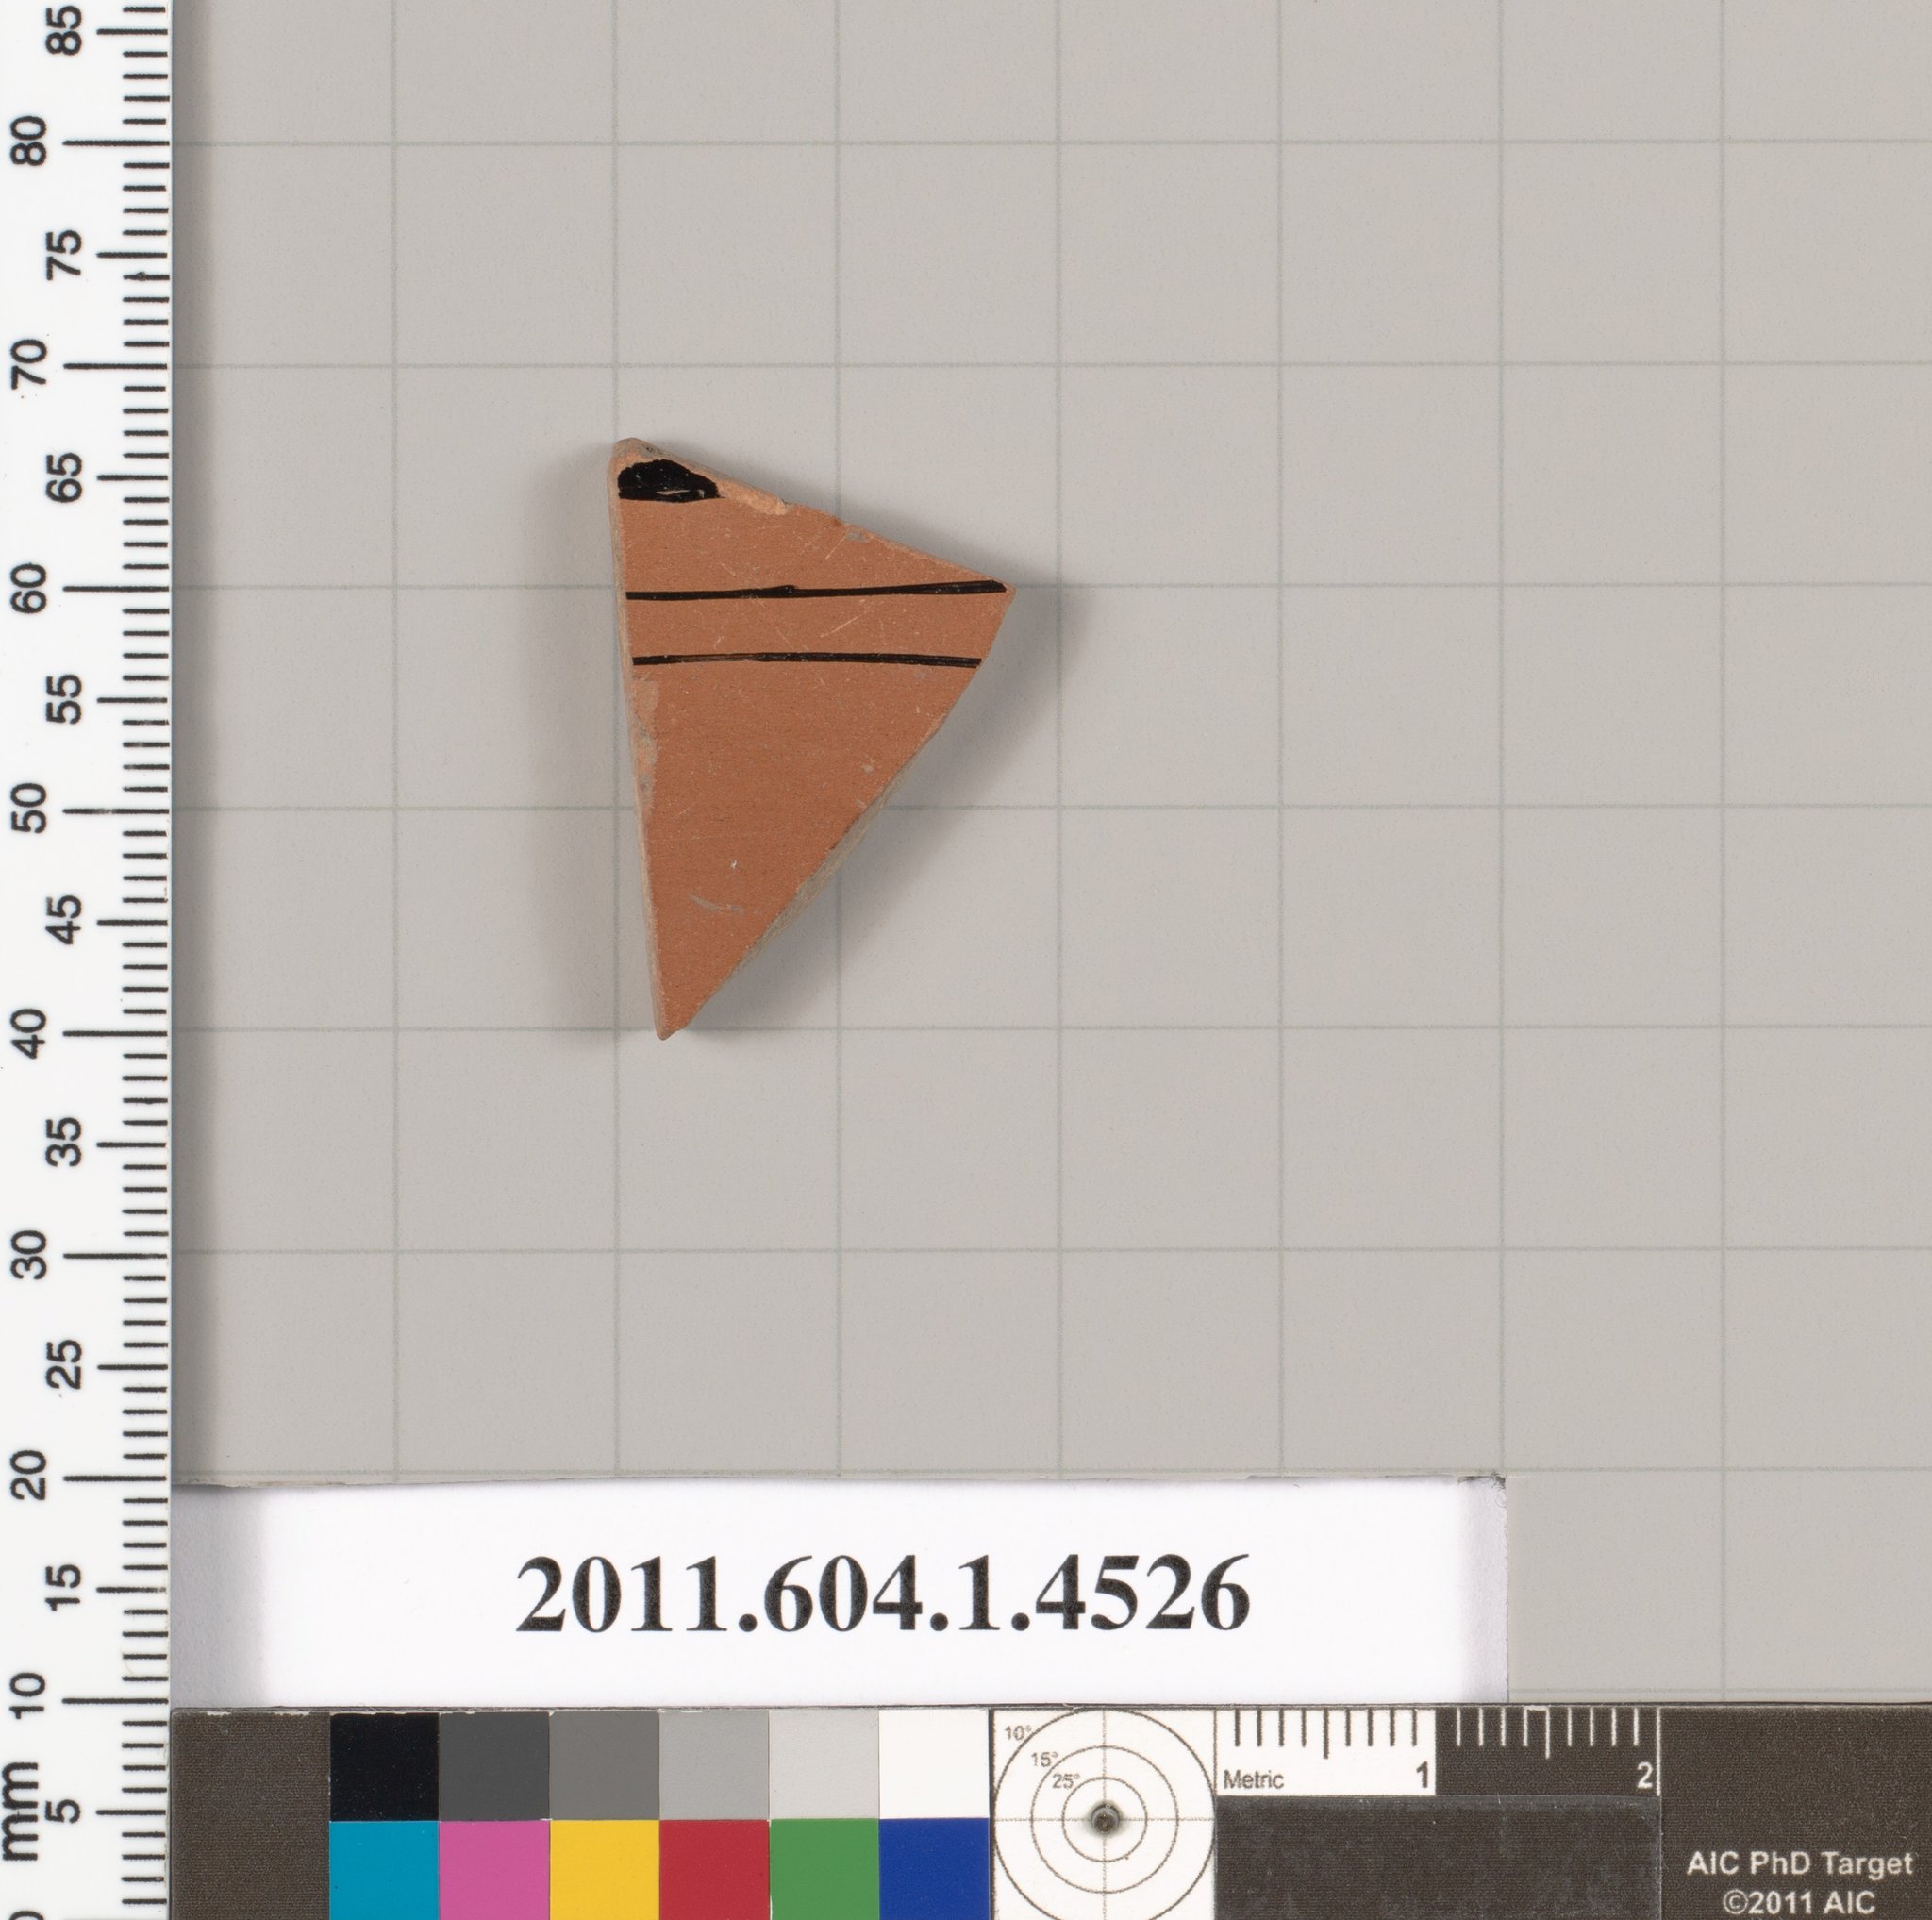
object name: kylix fragment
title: Terracotta fragment of a kylix (drinking cup)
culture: greek, attic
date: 500-480 BCE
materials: terracotta